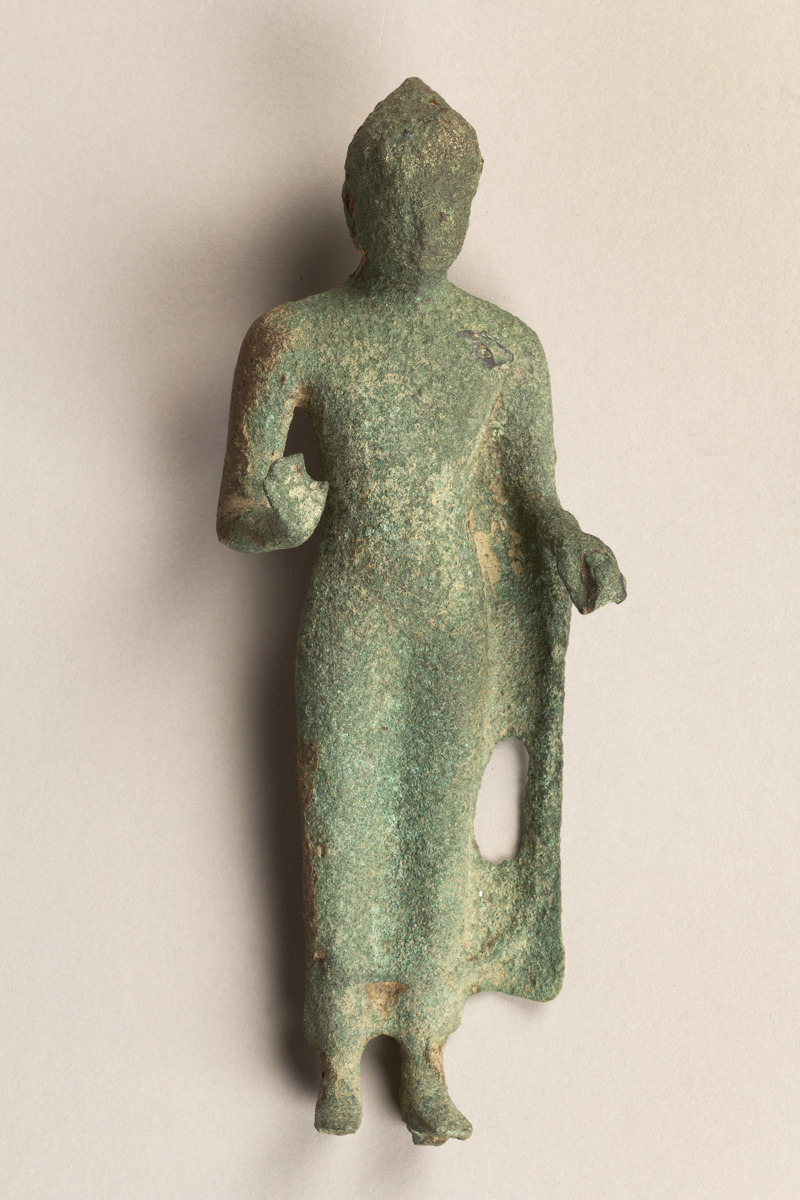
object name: fragment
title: Fragment of a Standing Buddha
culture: indonesian, kalimantan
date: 701-800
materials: bronze